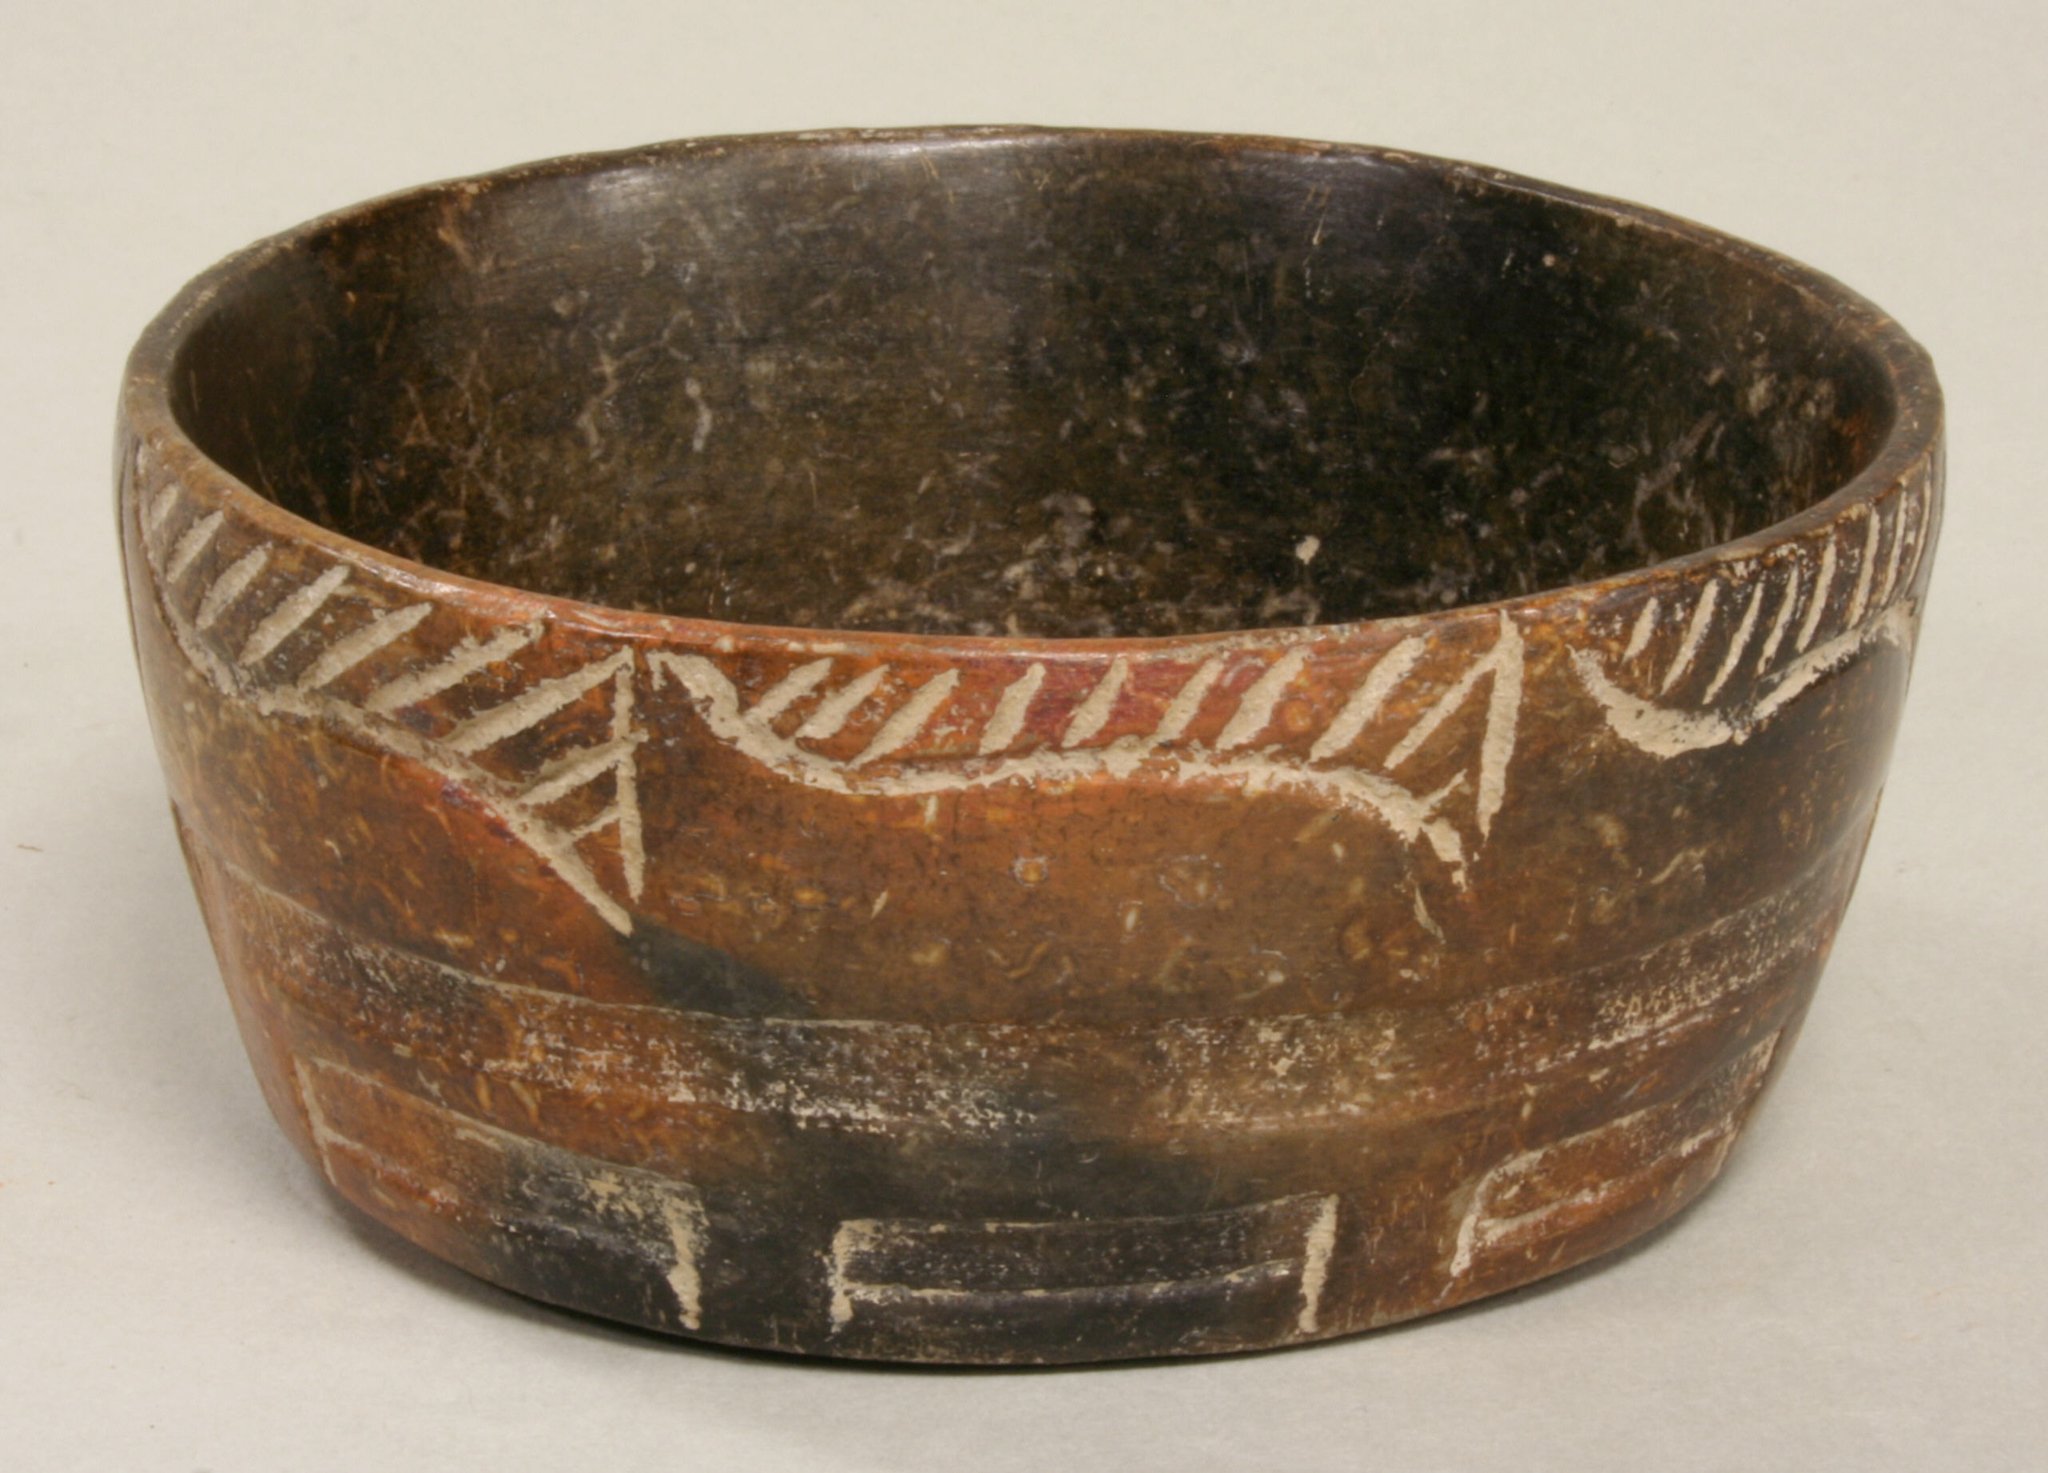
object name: bowl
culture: olmec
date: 1200-801 BCE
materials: ceramic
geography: mexico